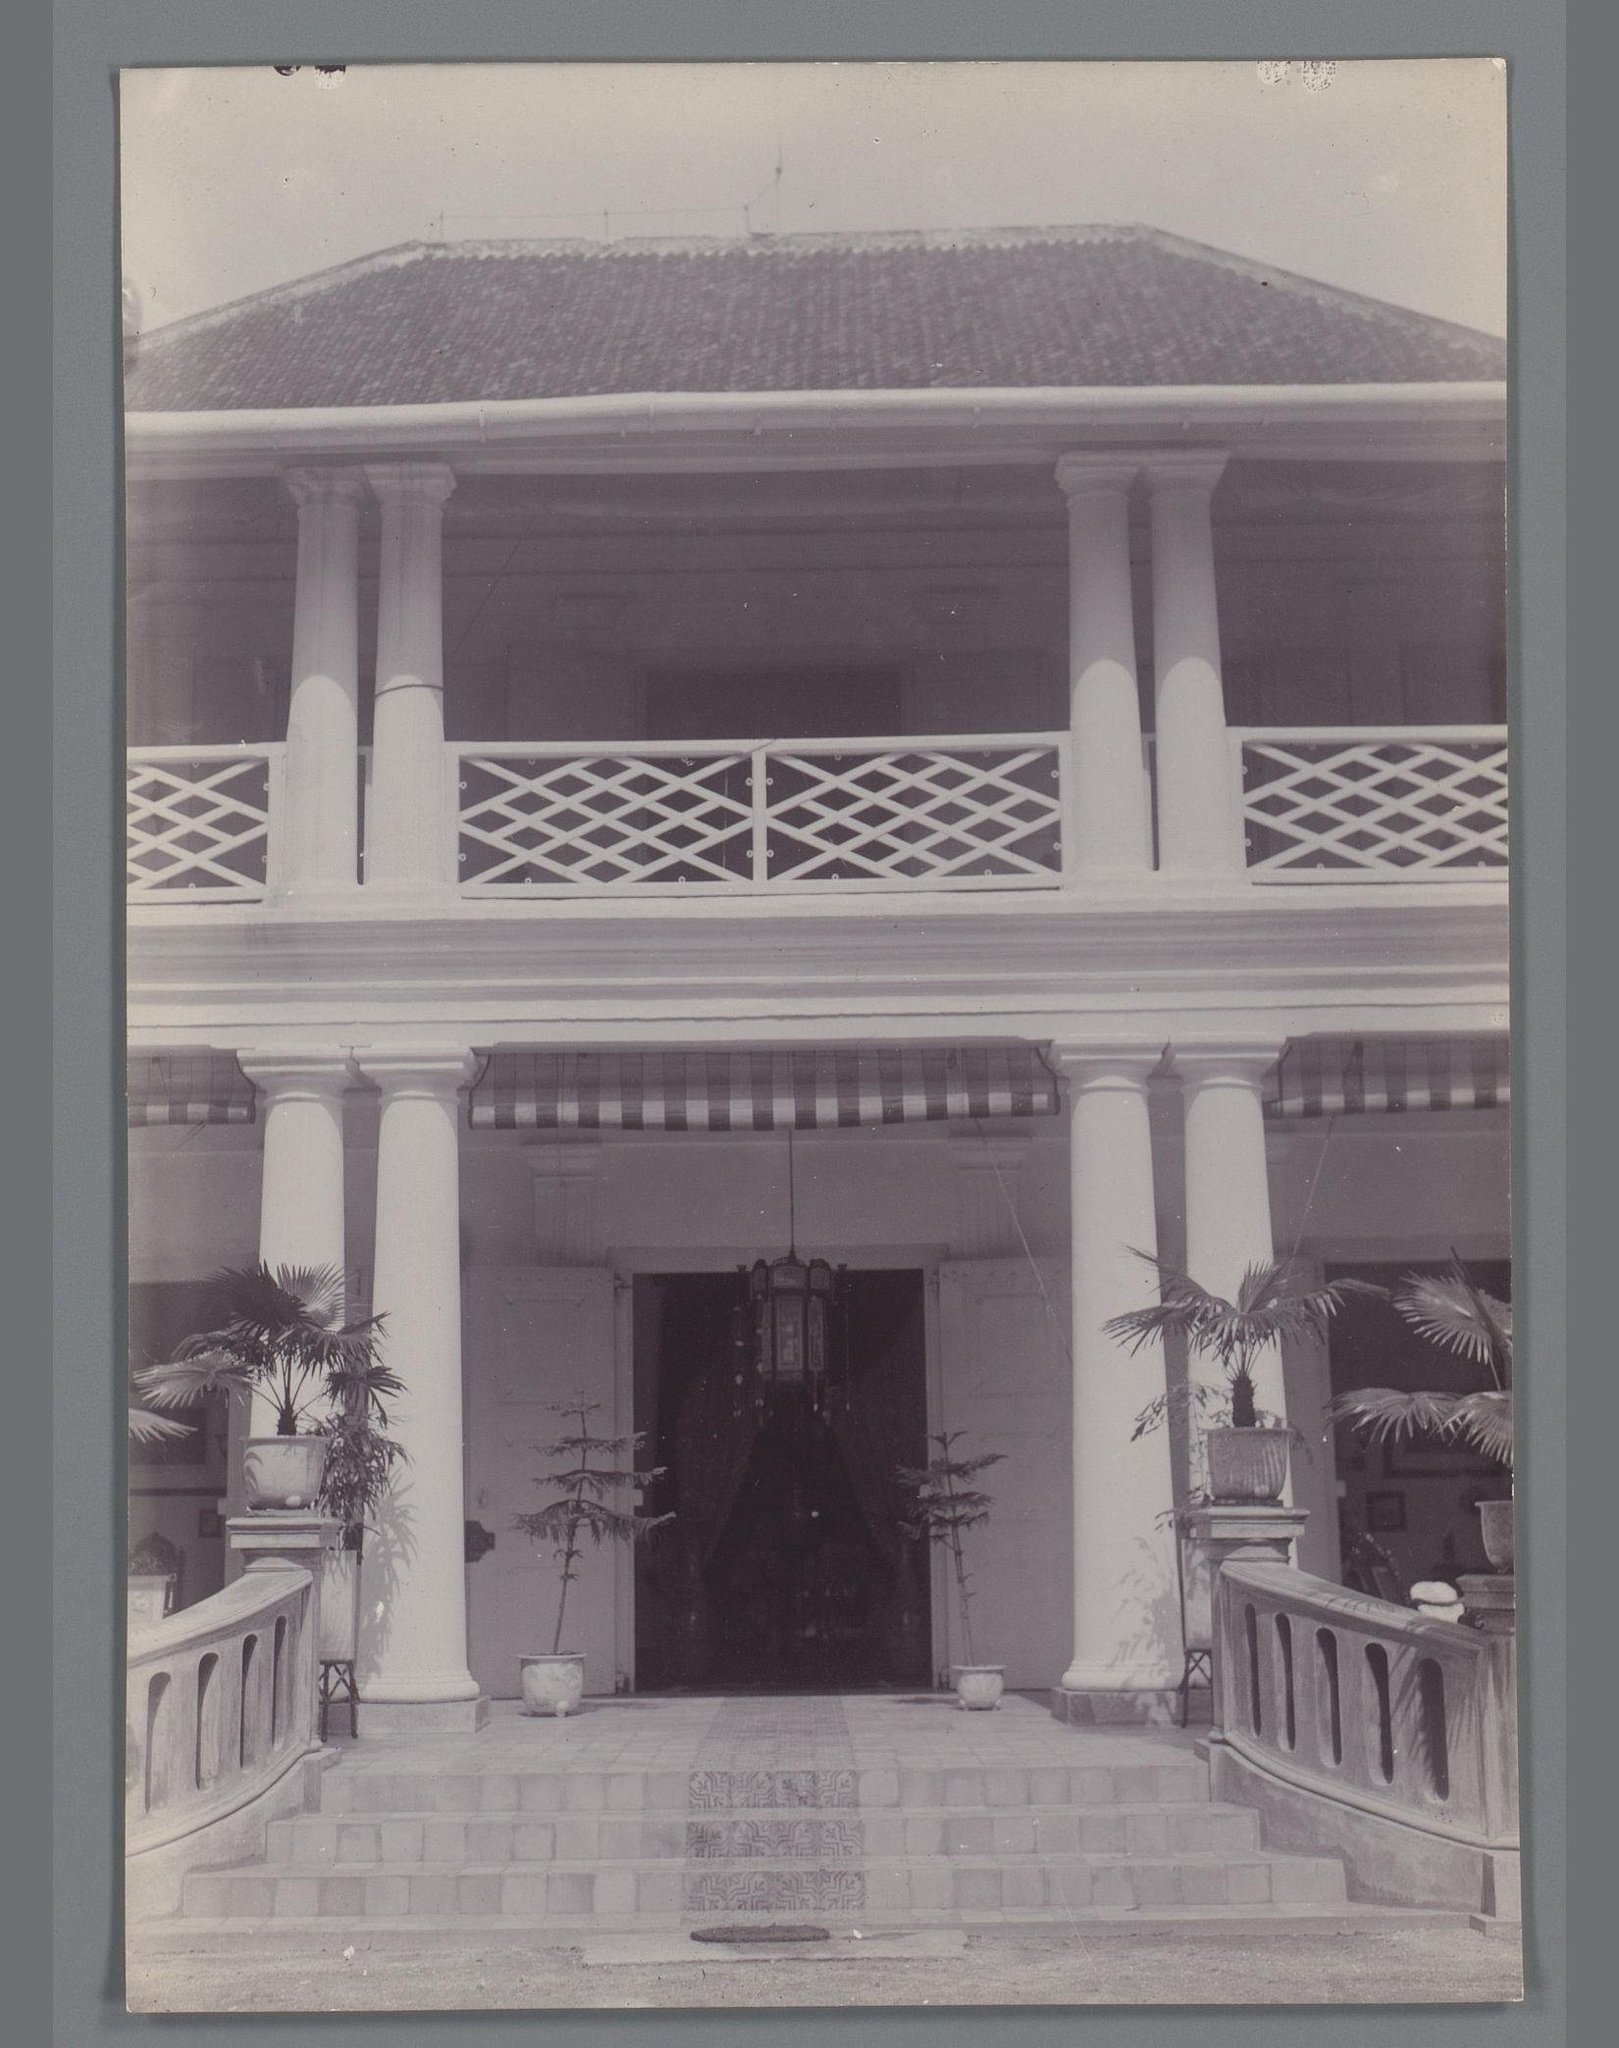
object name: photograph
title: Huis met veranda, Nederlands-Indië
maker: Anonymous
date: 1890-1920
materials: paper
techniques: matte daylight collodion silver print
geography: dutch east indies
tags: front steps, loggia, verandah, porch, dutch east indies, the